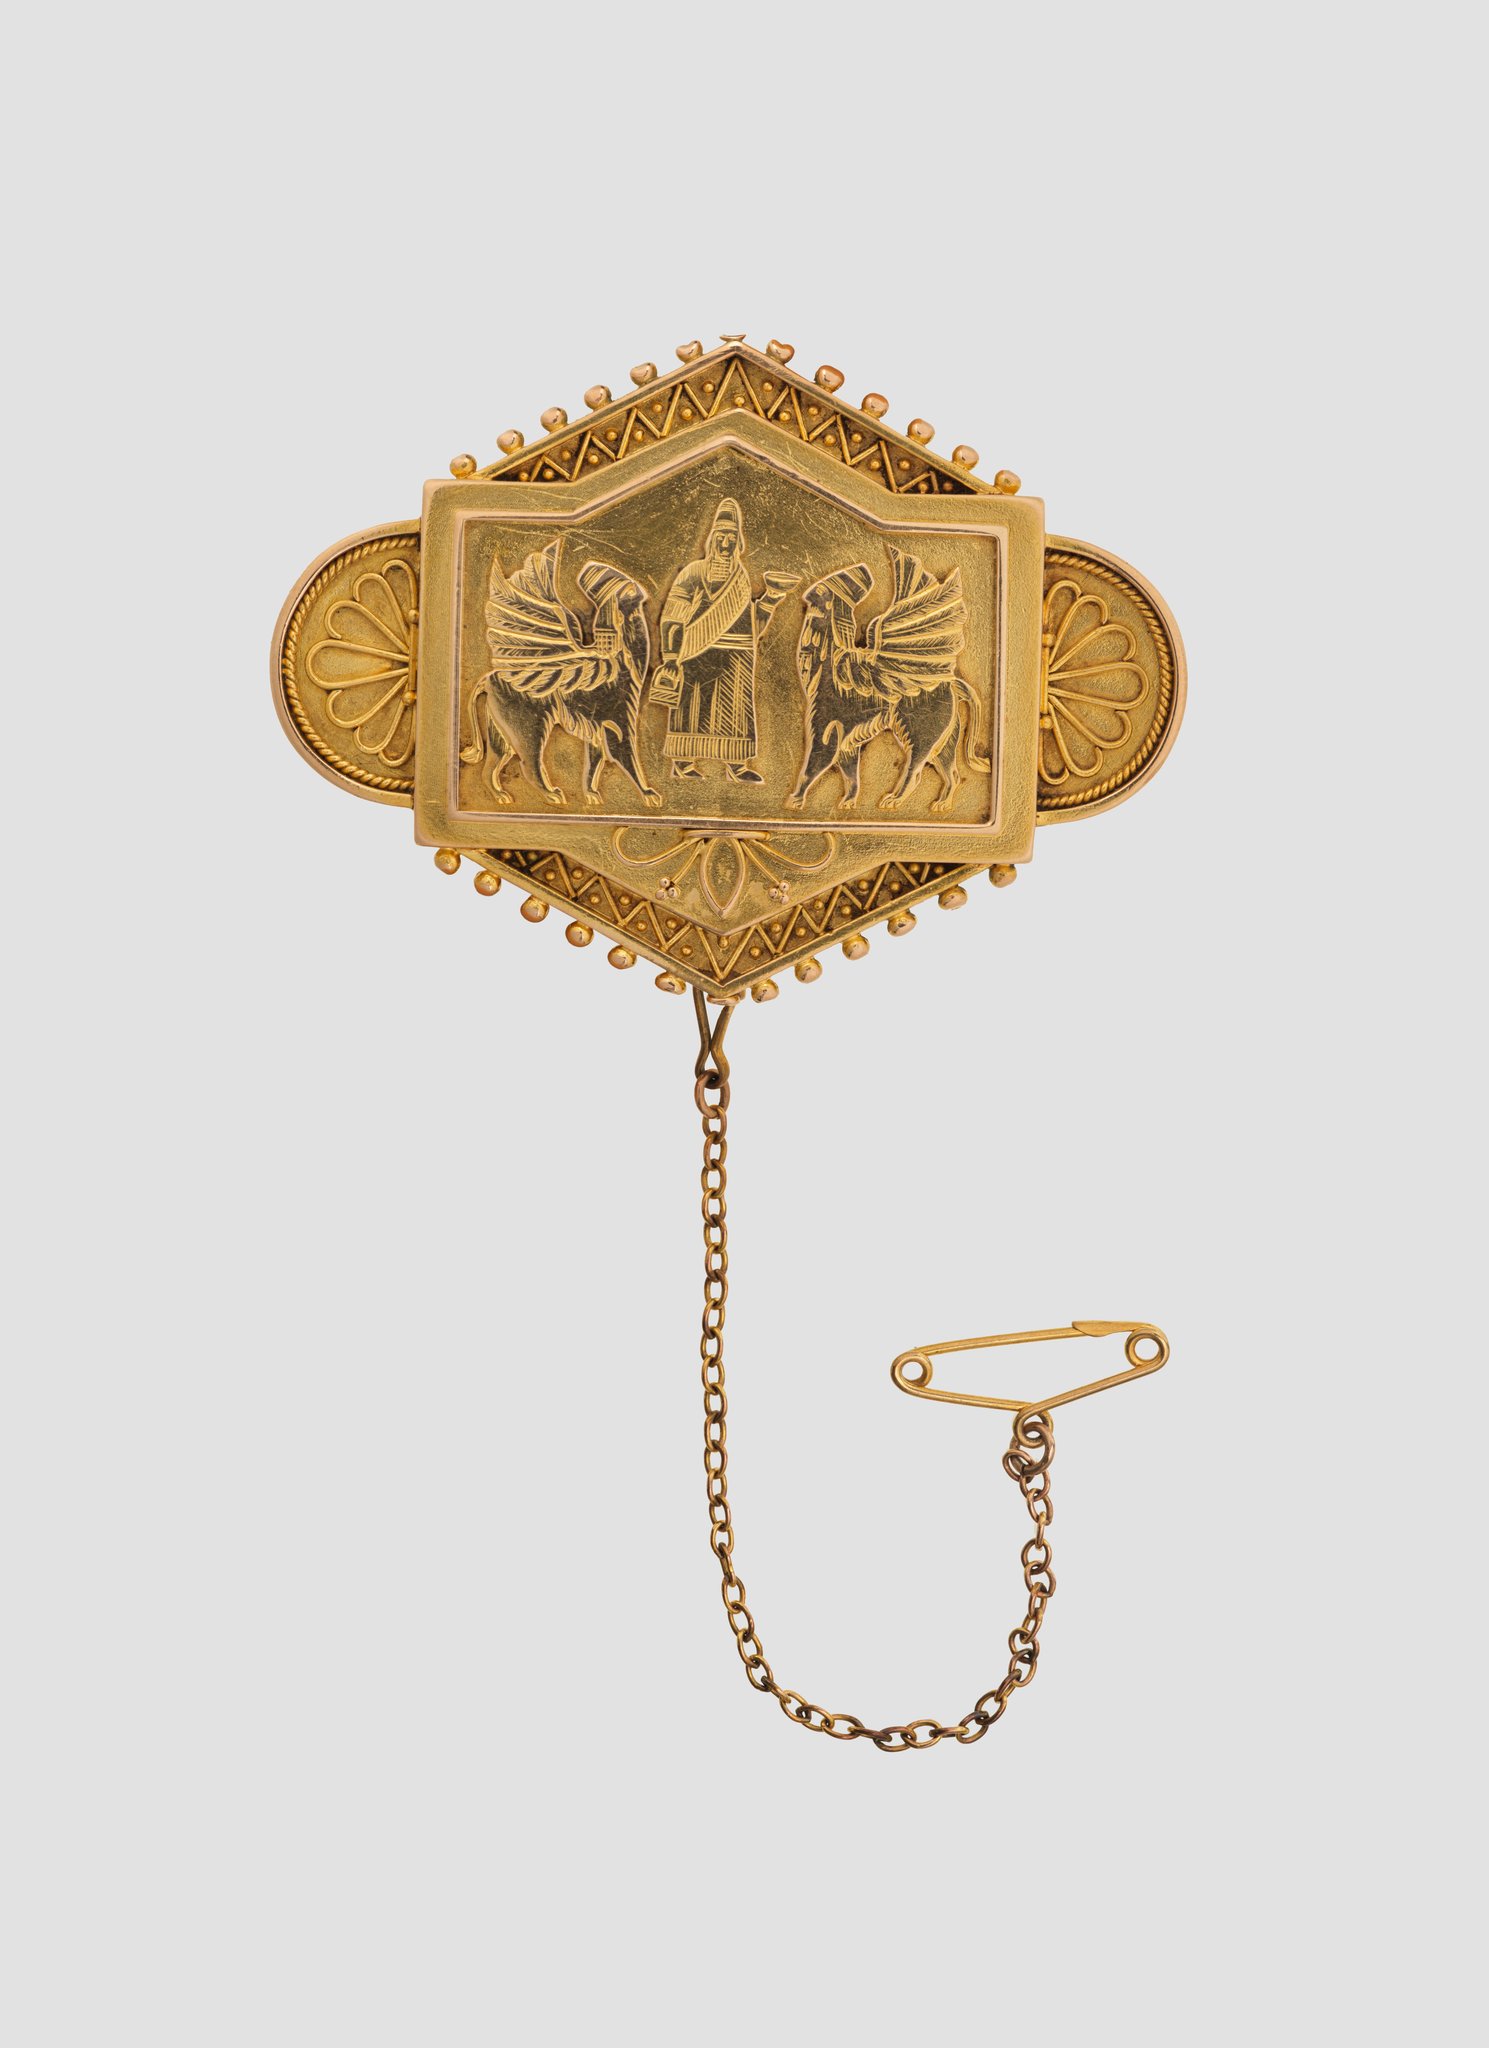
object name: brooch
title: Brooch with Assyrian-inspired design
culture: british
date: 1851-1900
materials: gold